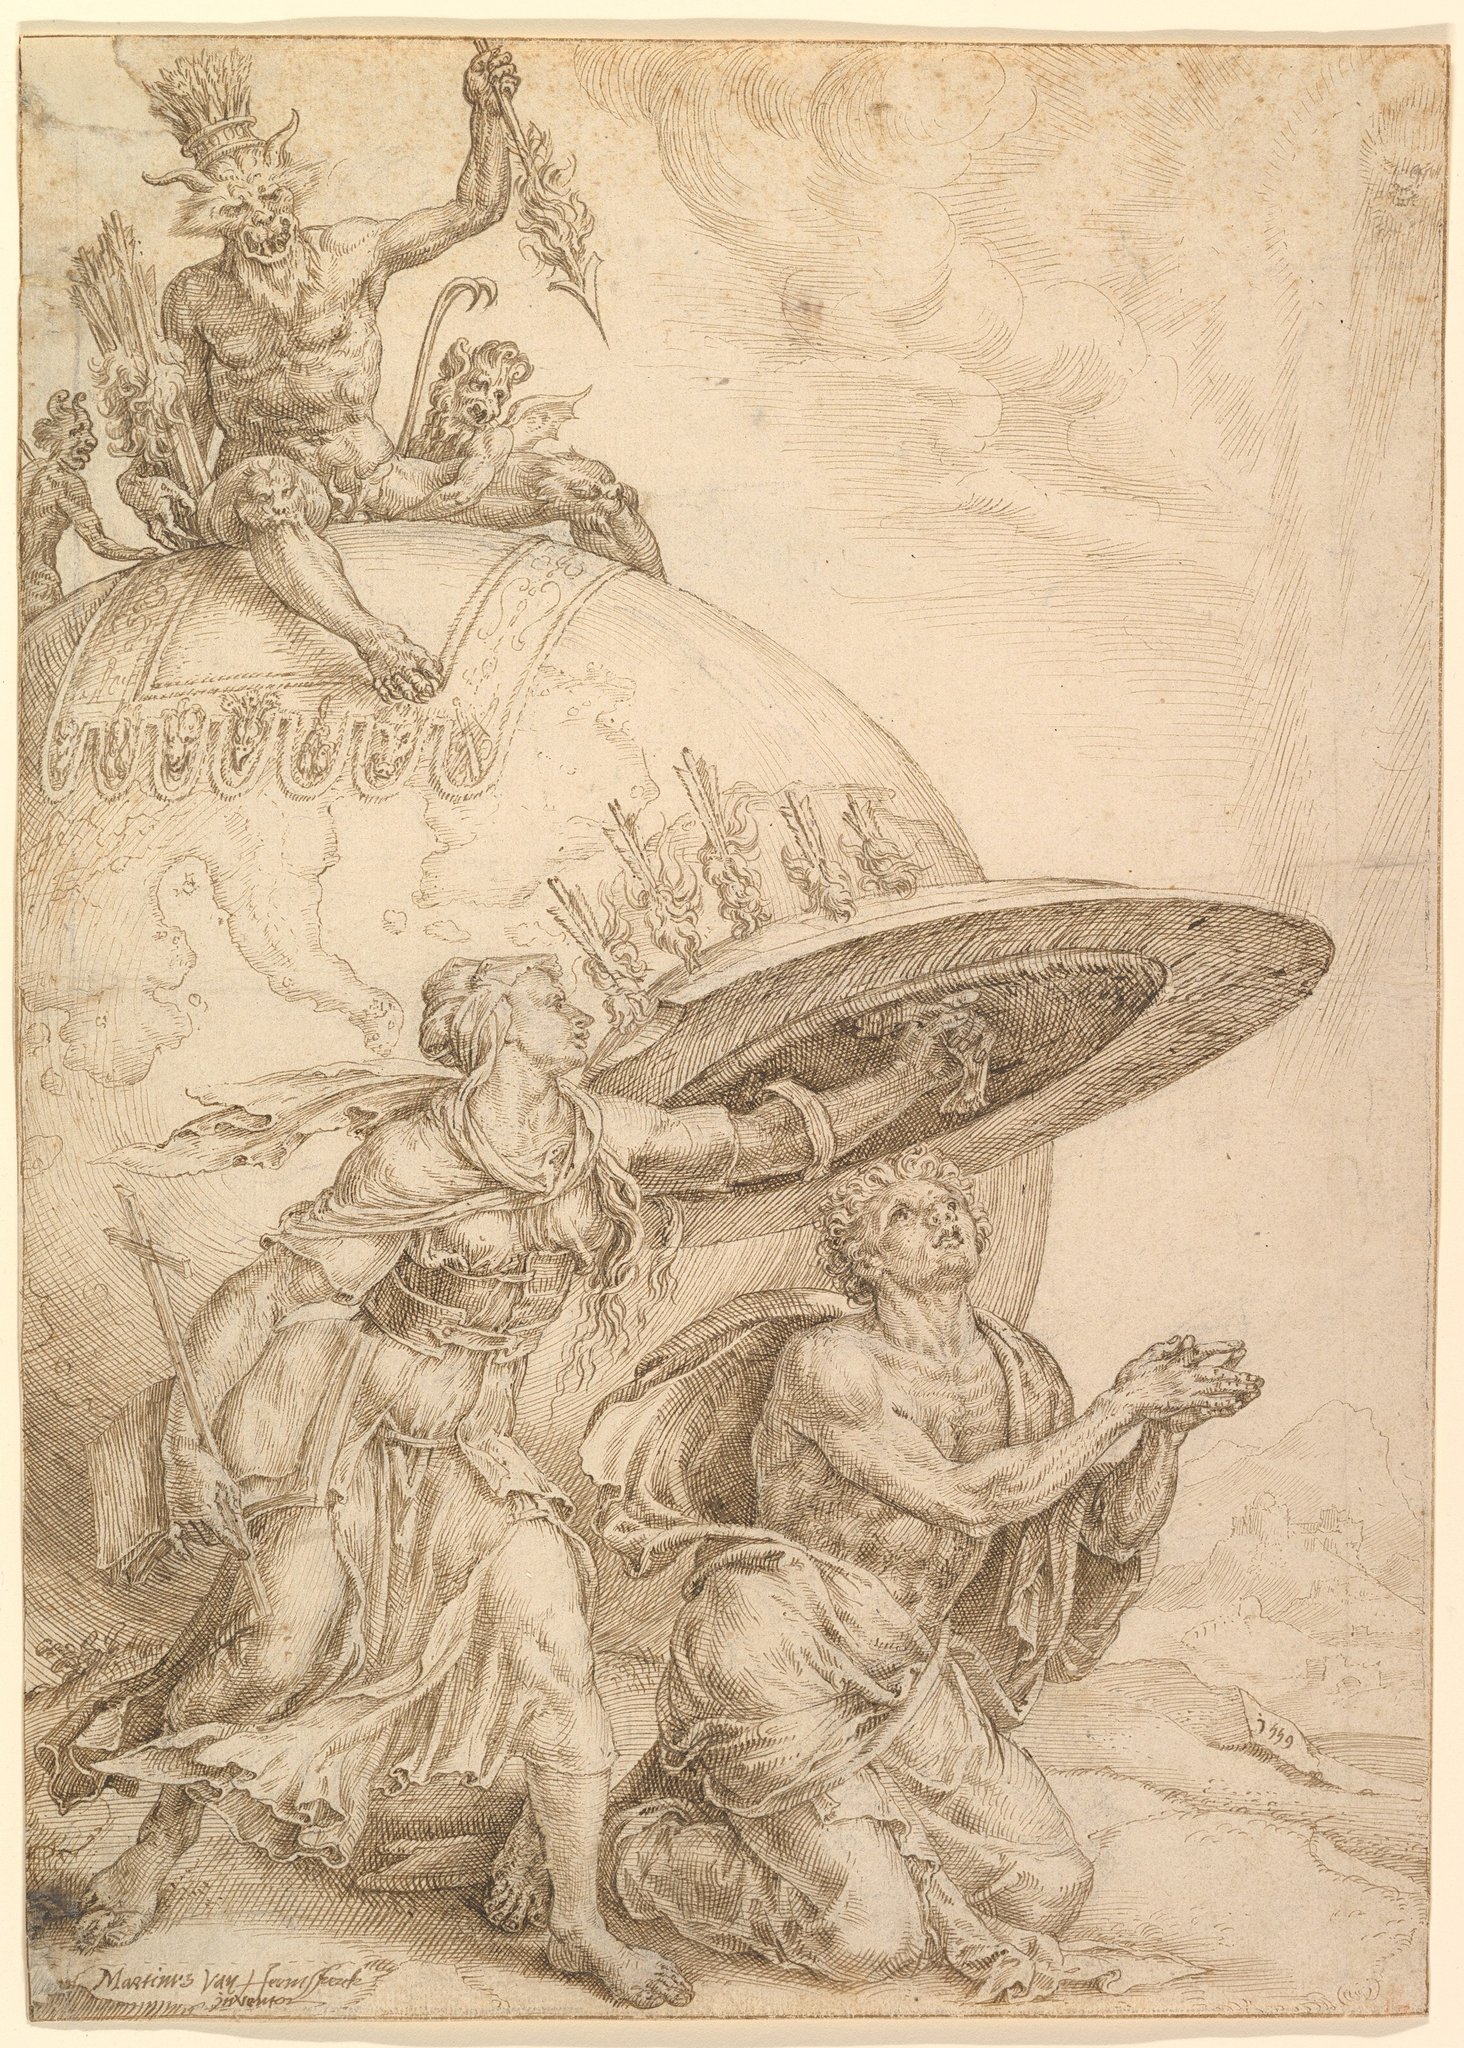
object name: drawing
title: Man Protected by the Shield of Faith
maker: maarten van heemskerck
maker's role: artist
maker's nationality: netherlandish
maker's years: 1498-1574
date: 1559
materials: chalk, ink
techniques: pen, transfer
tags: shields,men,women,devil,globes